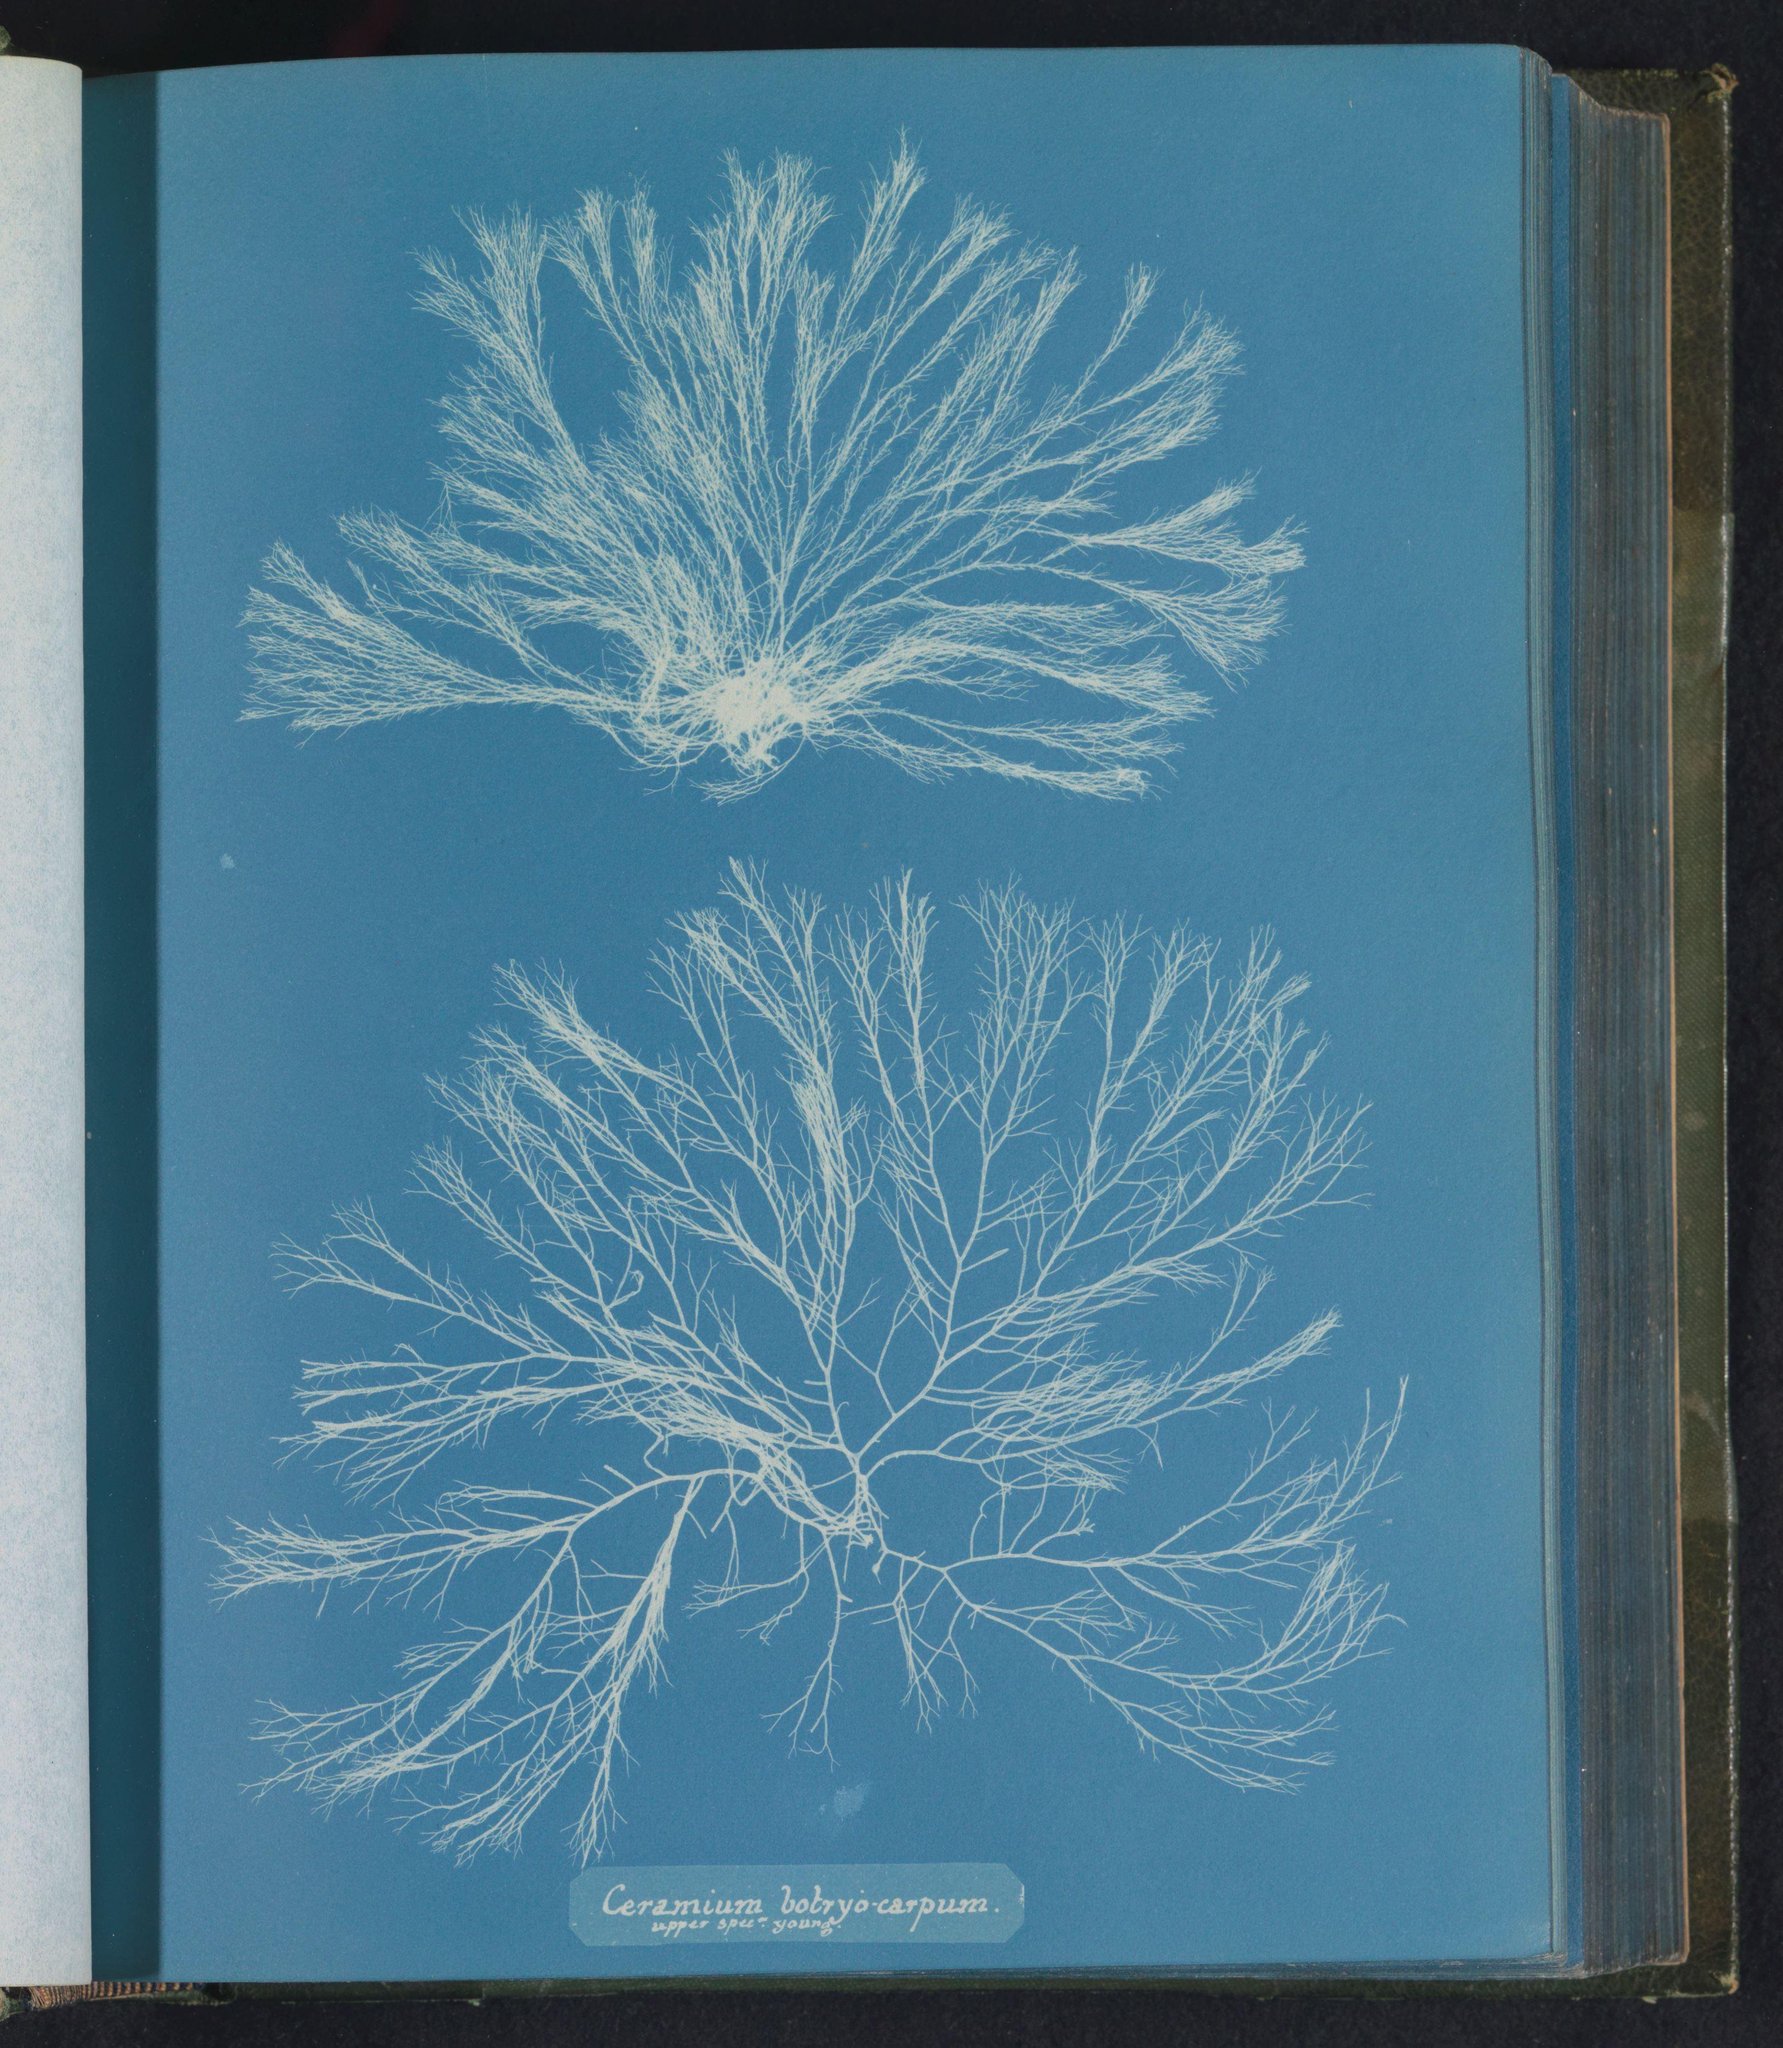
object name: page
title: Zeewier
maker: anna atkins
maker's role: fotograaf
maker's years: 1799-1871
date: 1843-1853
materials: photographic support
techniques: cyanotype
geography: united kingdom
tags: algae, seaweed